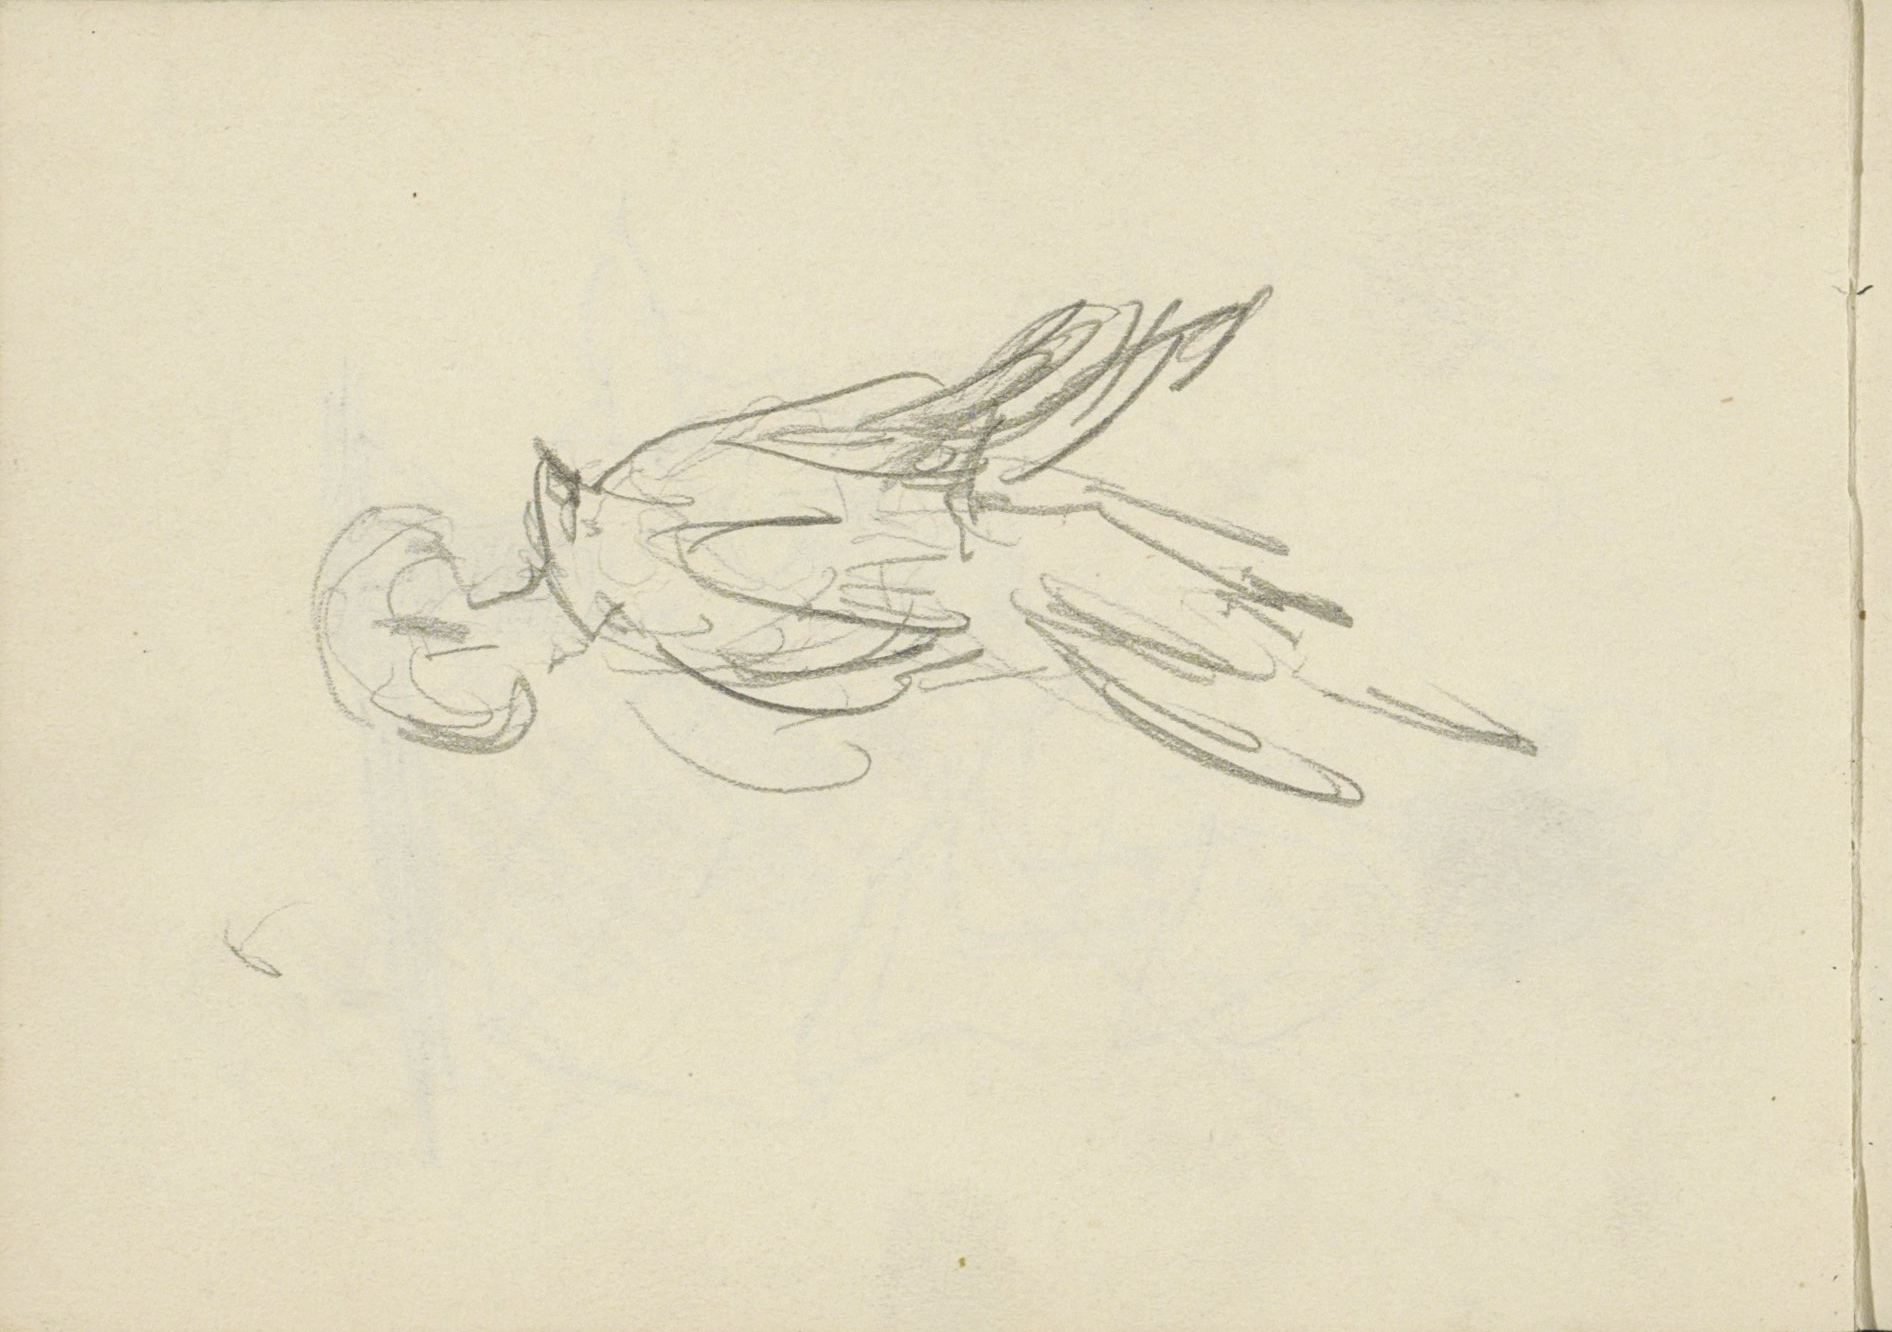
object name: sketchbook leaf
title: Staande vrouw, in profiel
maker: isaac israels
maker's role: draughtsman, painter, print maker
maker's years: 1865-1934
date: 1930-1934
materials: paper, pencil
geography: the hague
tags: adult woman (+ standing)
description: Pagina 27 uit schetsboek XXXVIII met 45 pagina's.